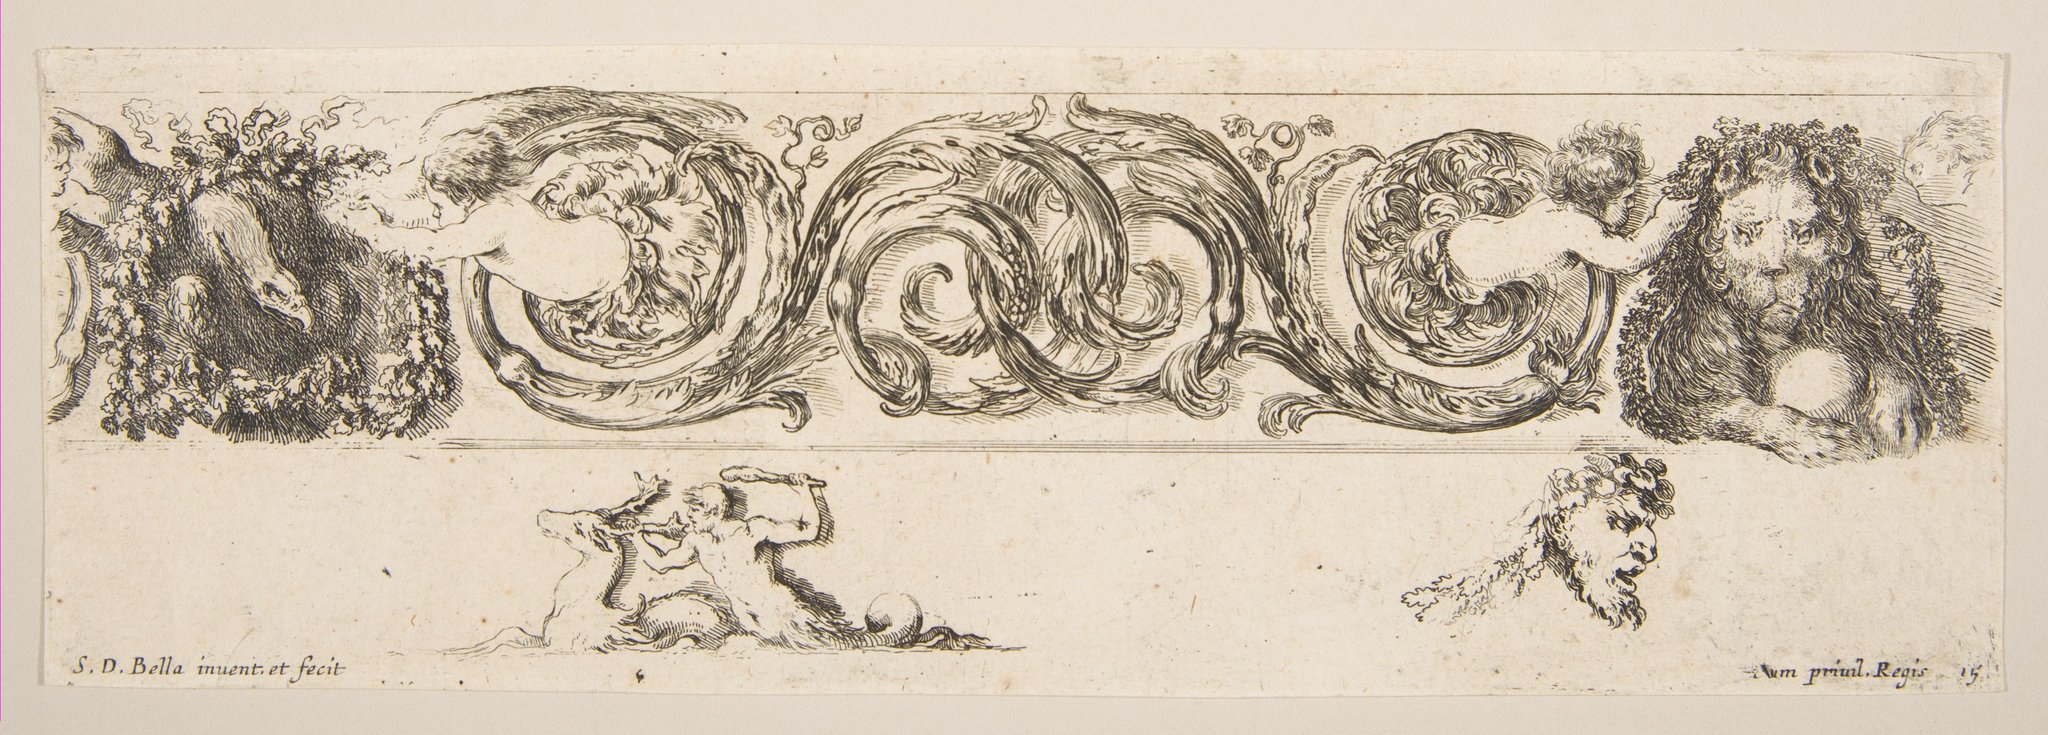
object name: print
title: Rinceaux with Eagle and Lion, plate 15 from "Decorative friezes and foliage" (Ornamenti di fregi e fogliami)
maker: stefano della bella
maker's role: artist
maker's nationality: italian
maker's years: 1610-1664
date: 1648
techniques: etching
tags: eagles,ornament,lions